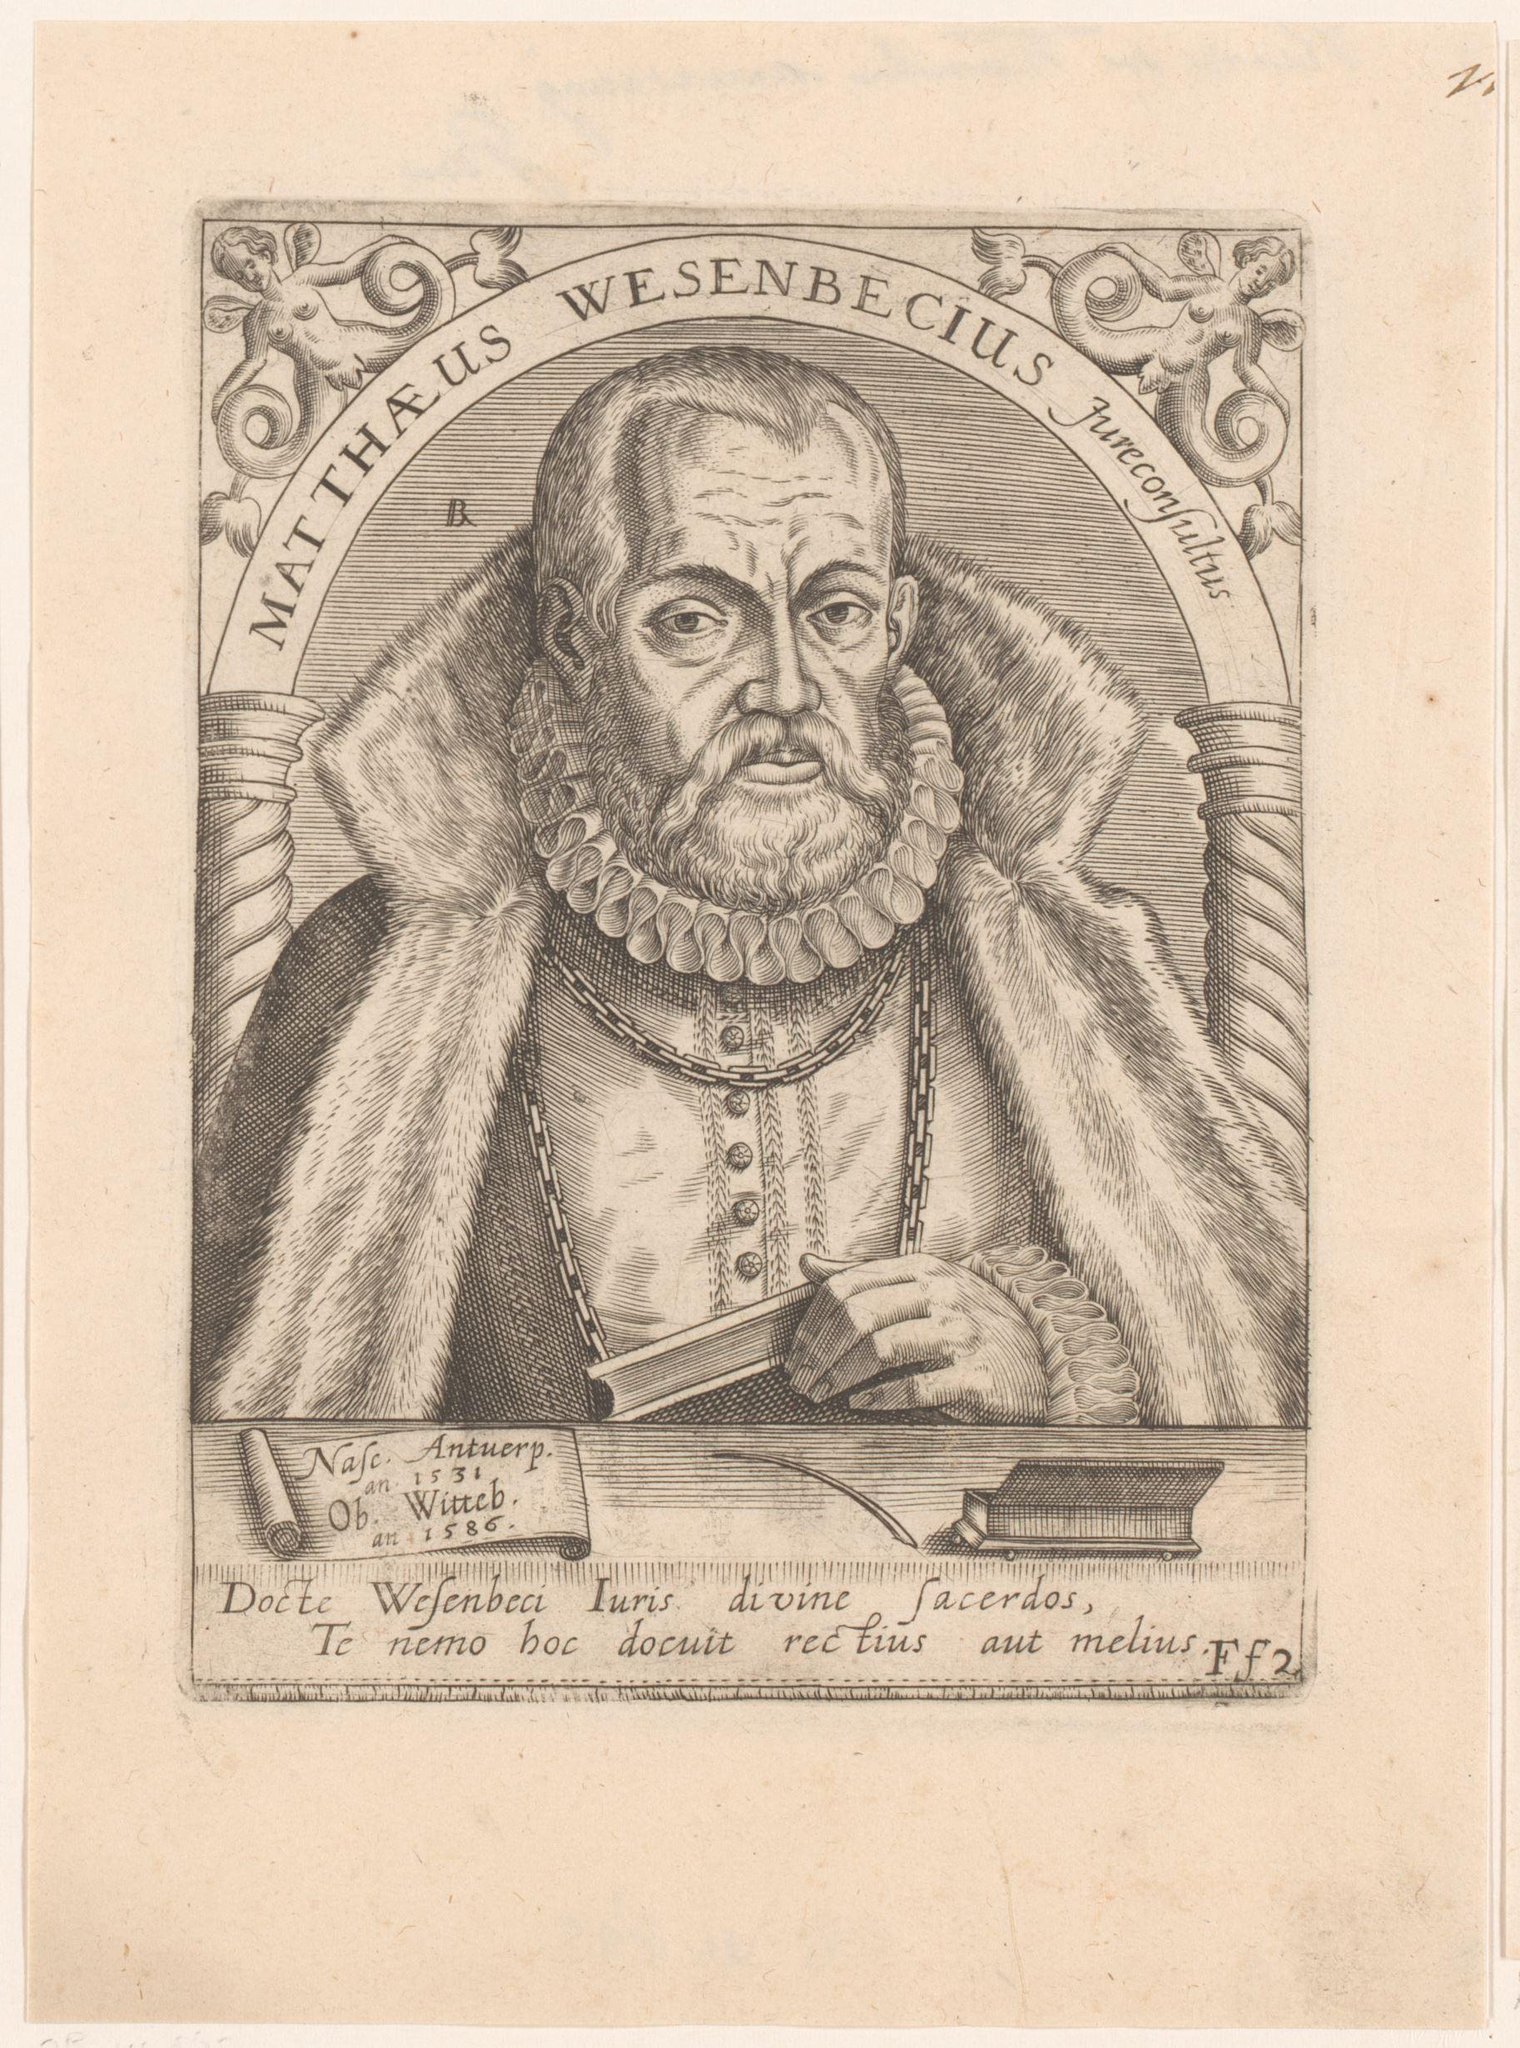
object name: print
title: Matthaeus Wesenbecius Jureconsultus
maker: robert boissard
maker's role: print maker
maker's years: 1570-1611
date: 1597-1599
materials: paper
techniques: engraving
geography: france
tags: antwerp, historical persons, book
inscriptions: collector's mark: Lugt 2228